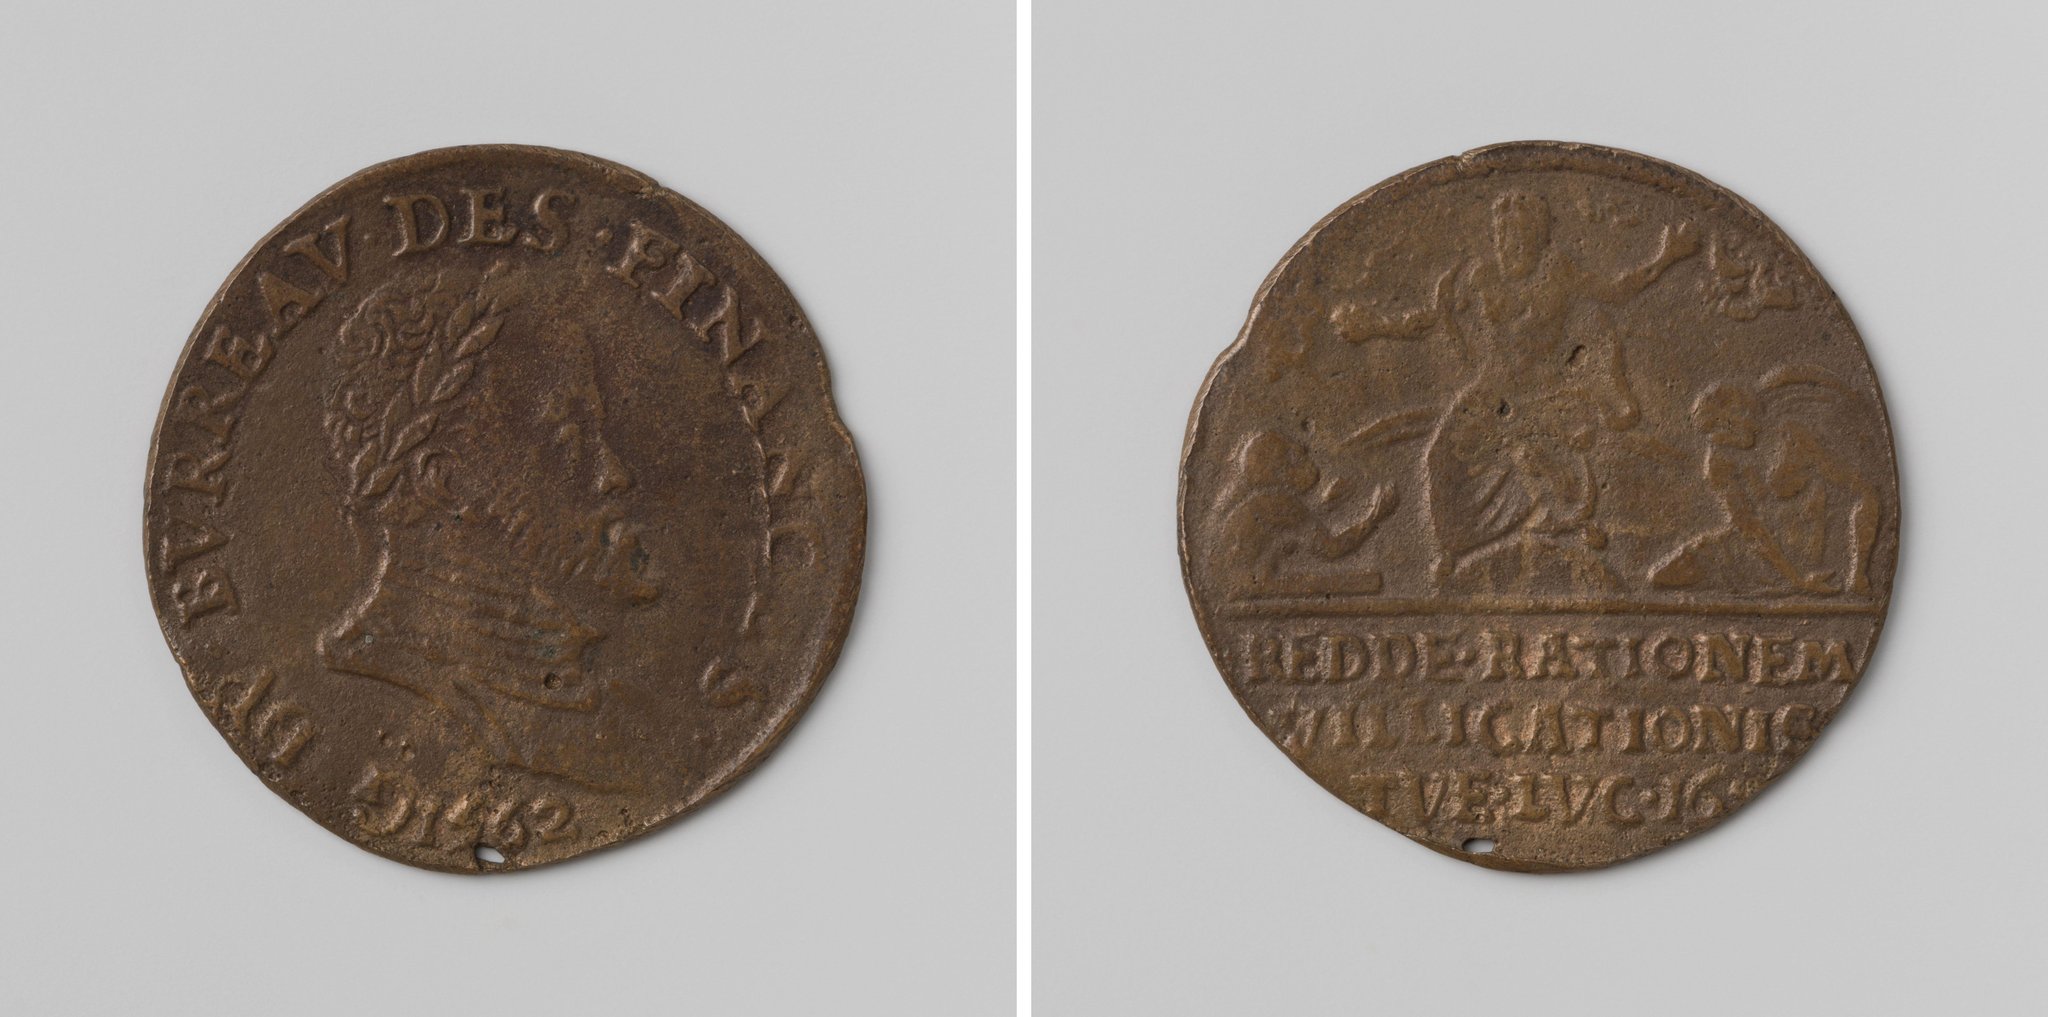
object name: jeton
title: Filips II, koning van Spanje, rekenpenning van de raad van Financiën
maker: Anonymous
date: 1562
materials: copper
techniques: striking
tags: philip ii of spain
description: Koperen penning. Voorzijde: borststuk man met lauwerkrans binnen omschrift. Keerzijde: Christus met uitgestrekte handen, staande op wereldbol, geflankeerd door twee mensen; afsnede: opschrift